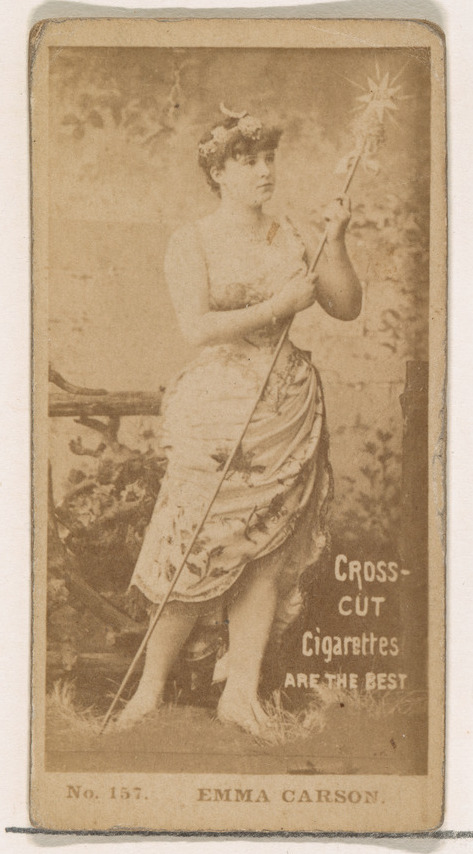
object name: print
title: Card Number 157, Emma Carson, from the Actors and Actresses series (N145-2) issued by Duke Sons & Co. to promote Cross Cut Cigarettes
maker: w. duke, sons & co.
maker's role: publisher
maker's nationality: american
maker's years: 1870-1920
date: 1880-1889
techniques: albumen silver print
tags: portraits,women,actresses